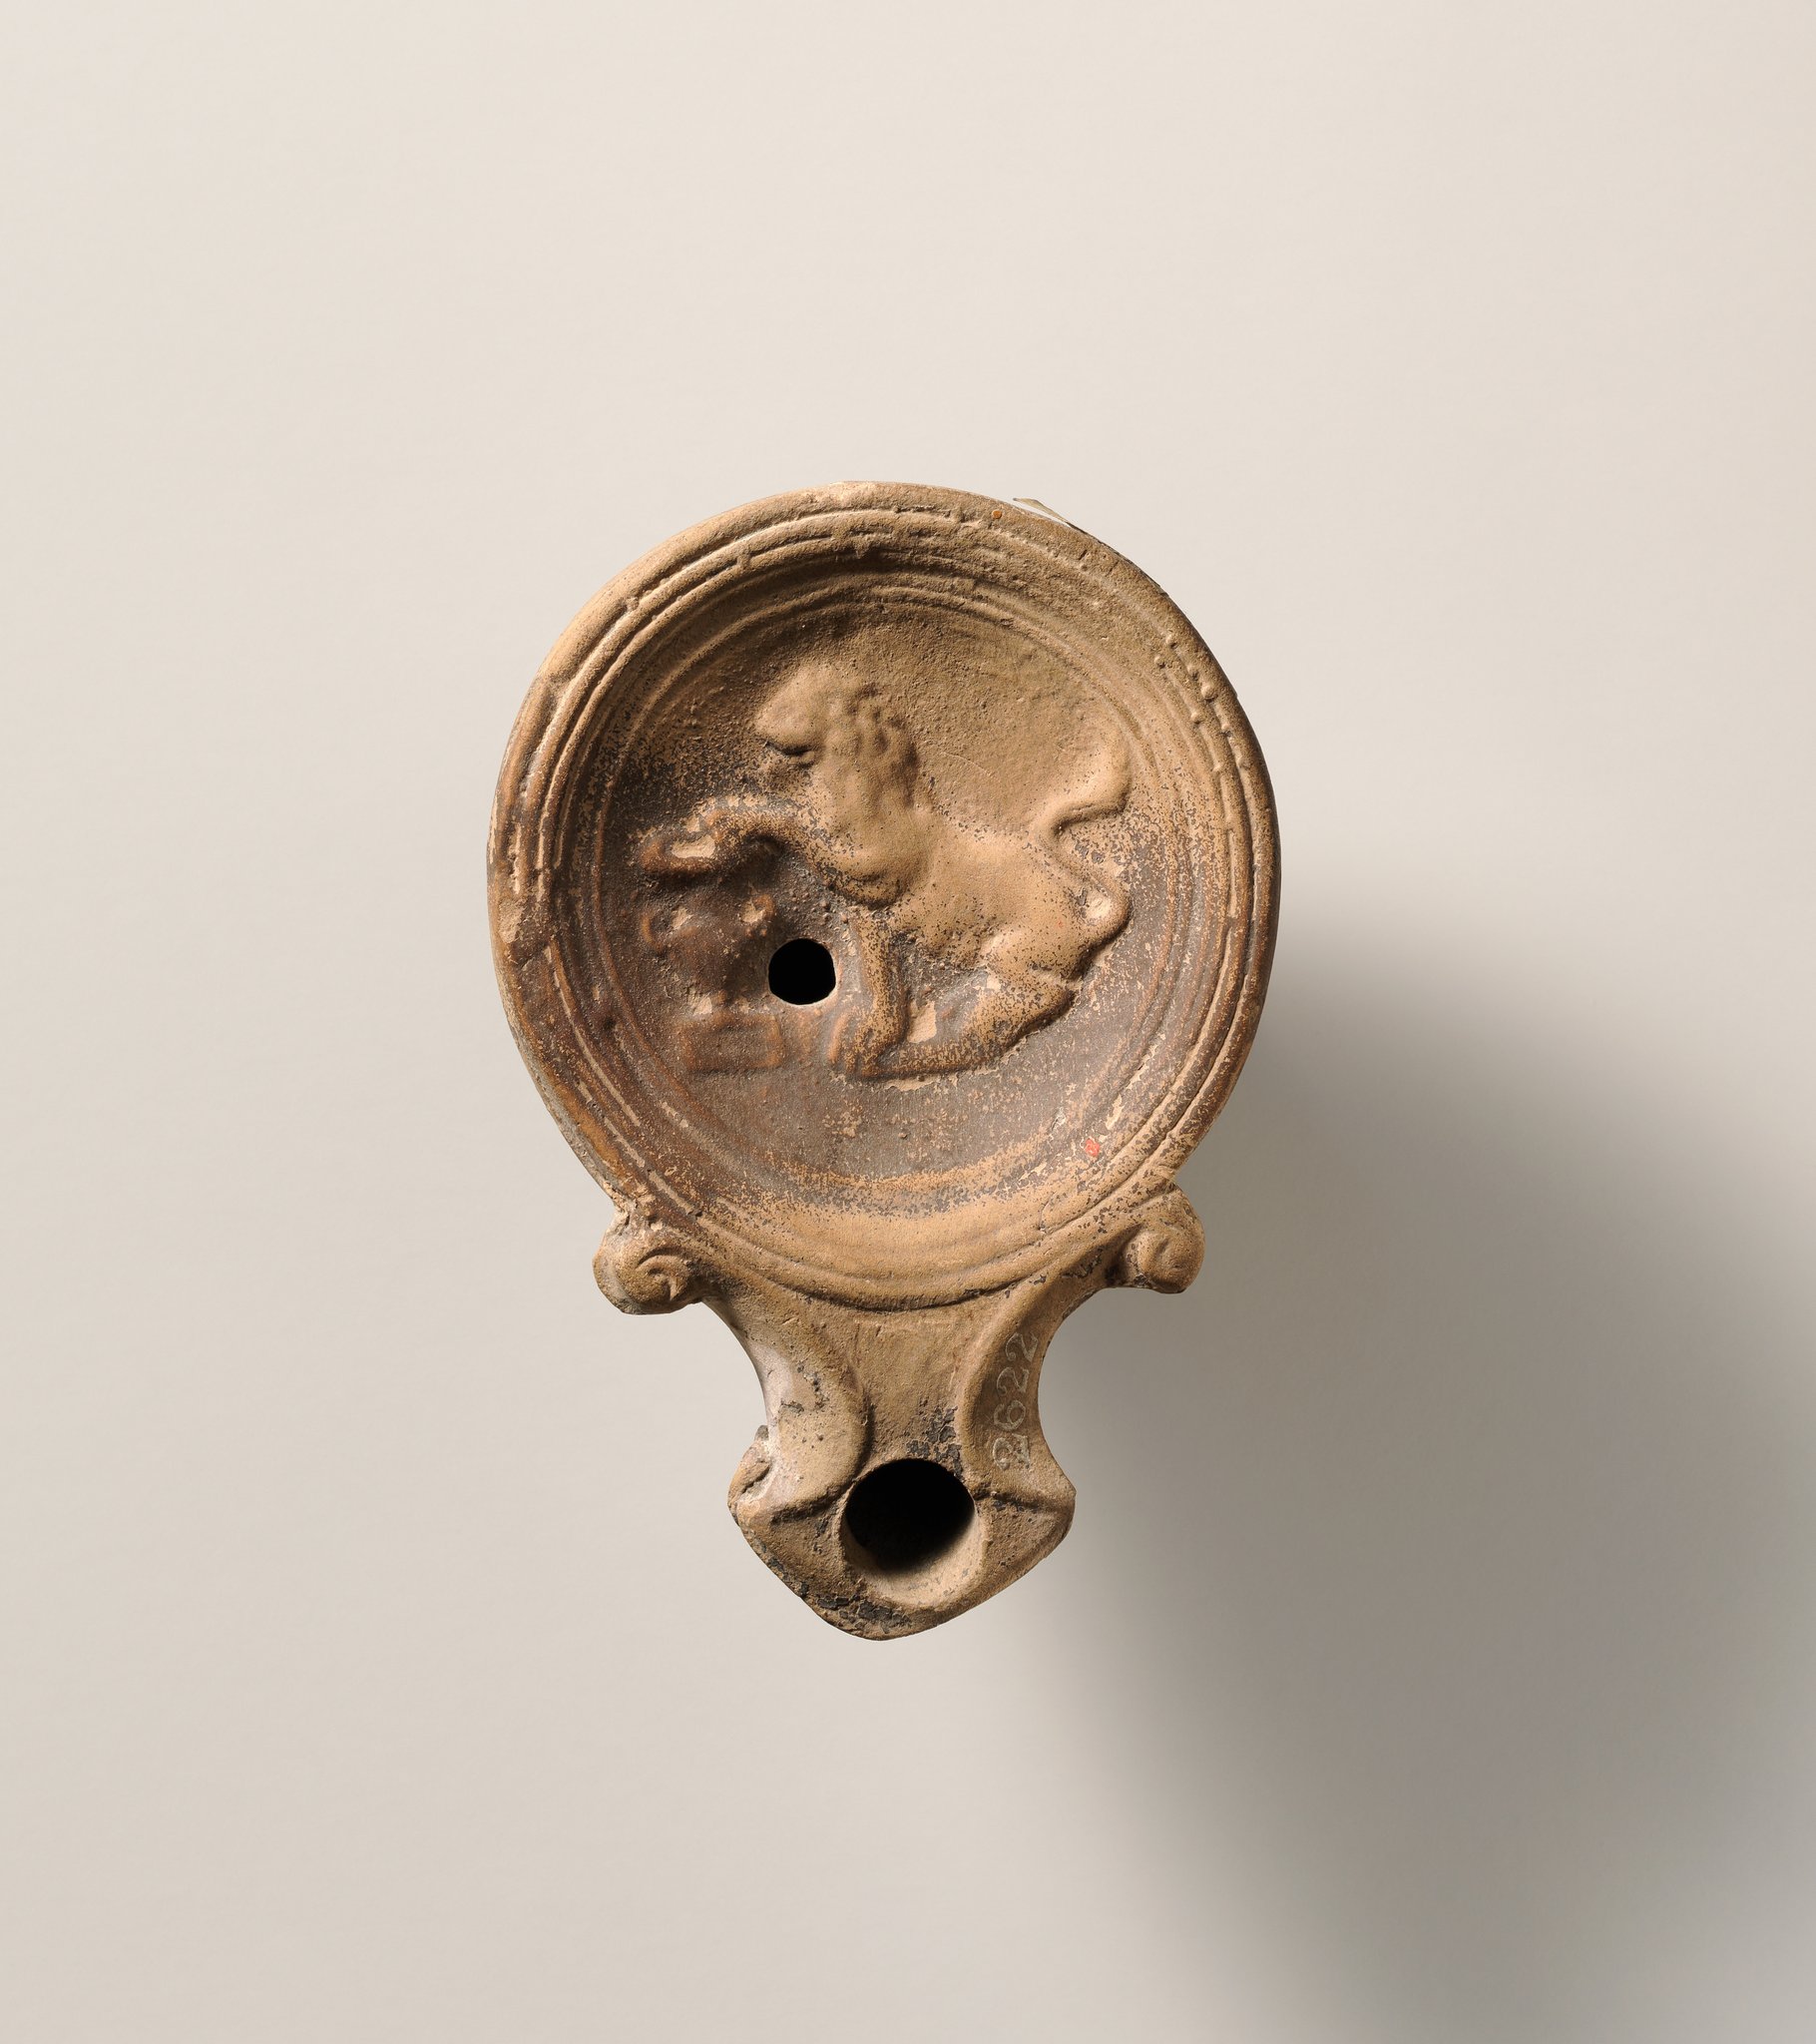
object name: lamp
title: Terracotta oil lamp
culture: roman, cypriot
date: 100 BCE-100 CE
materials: terracotta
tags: lions